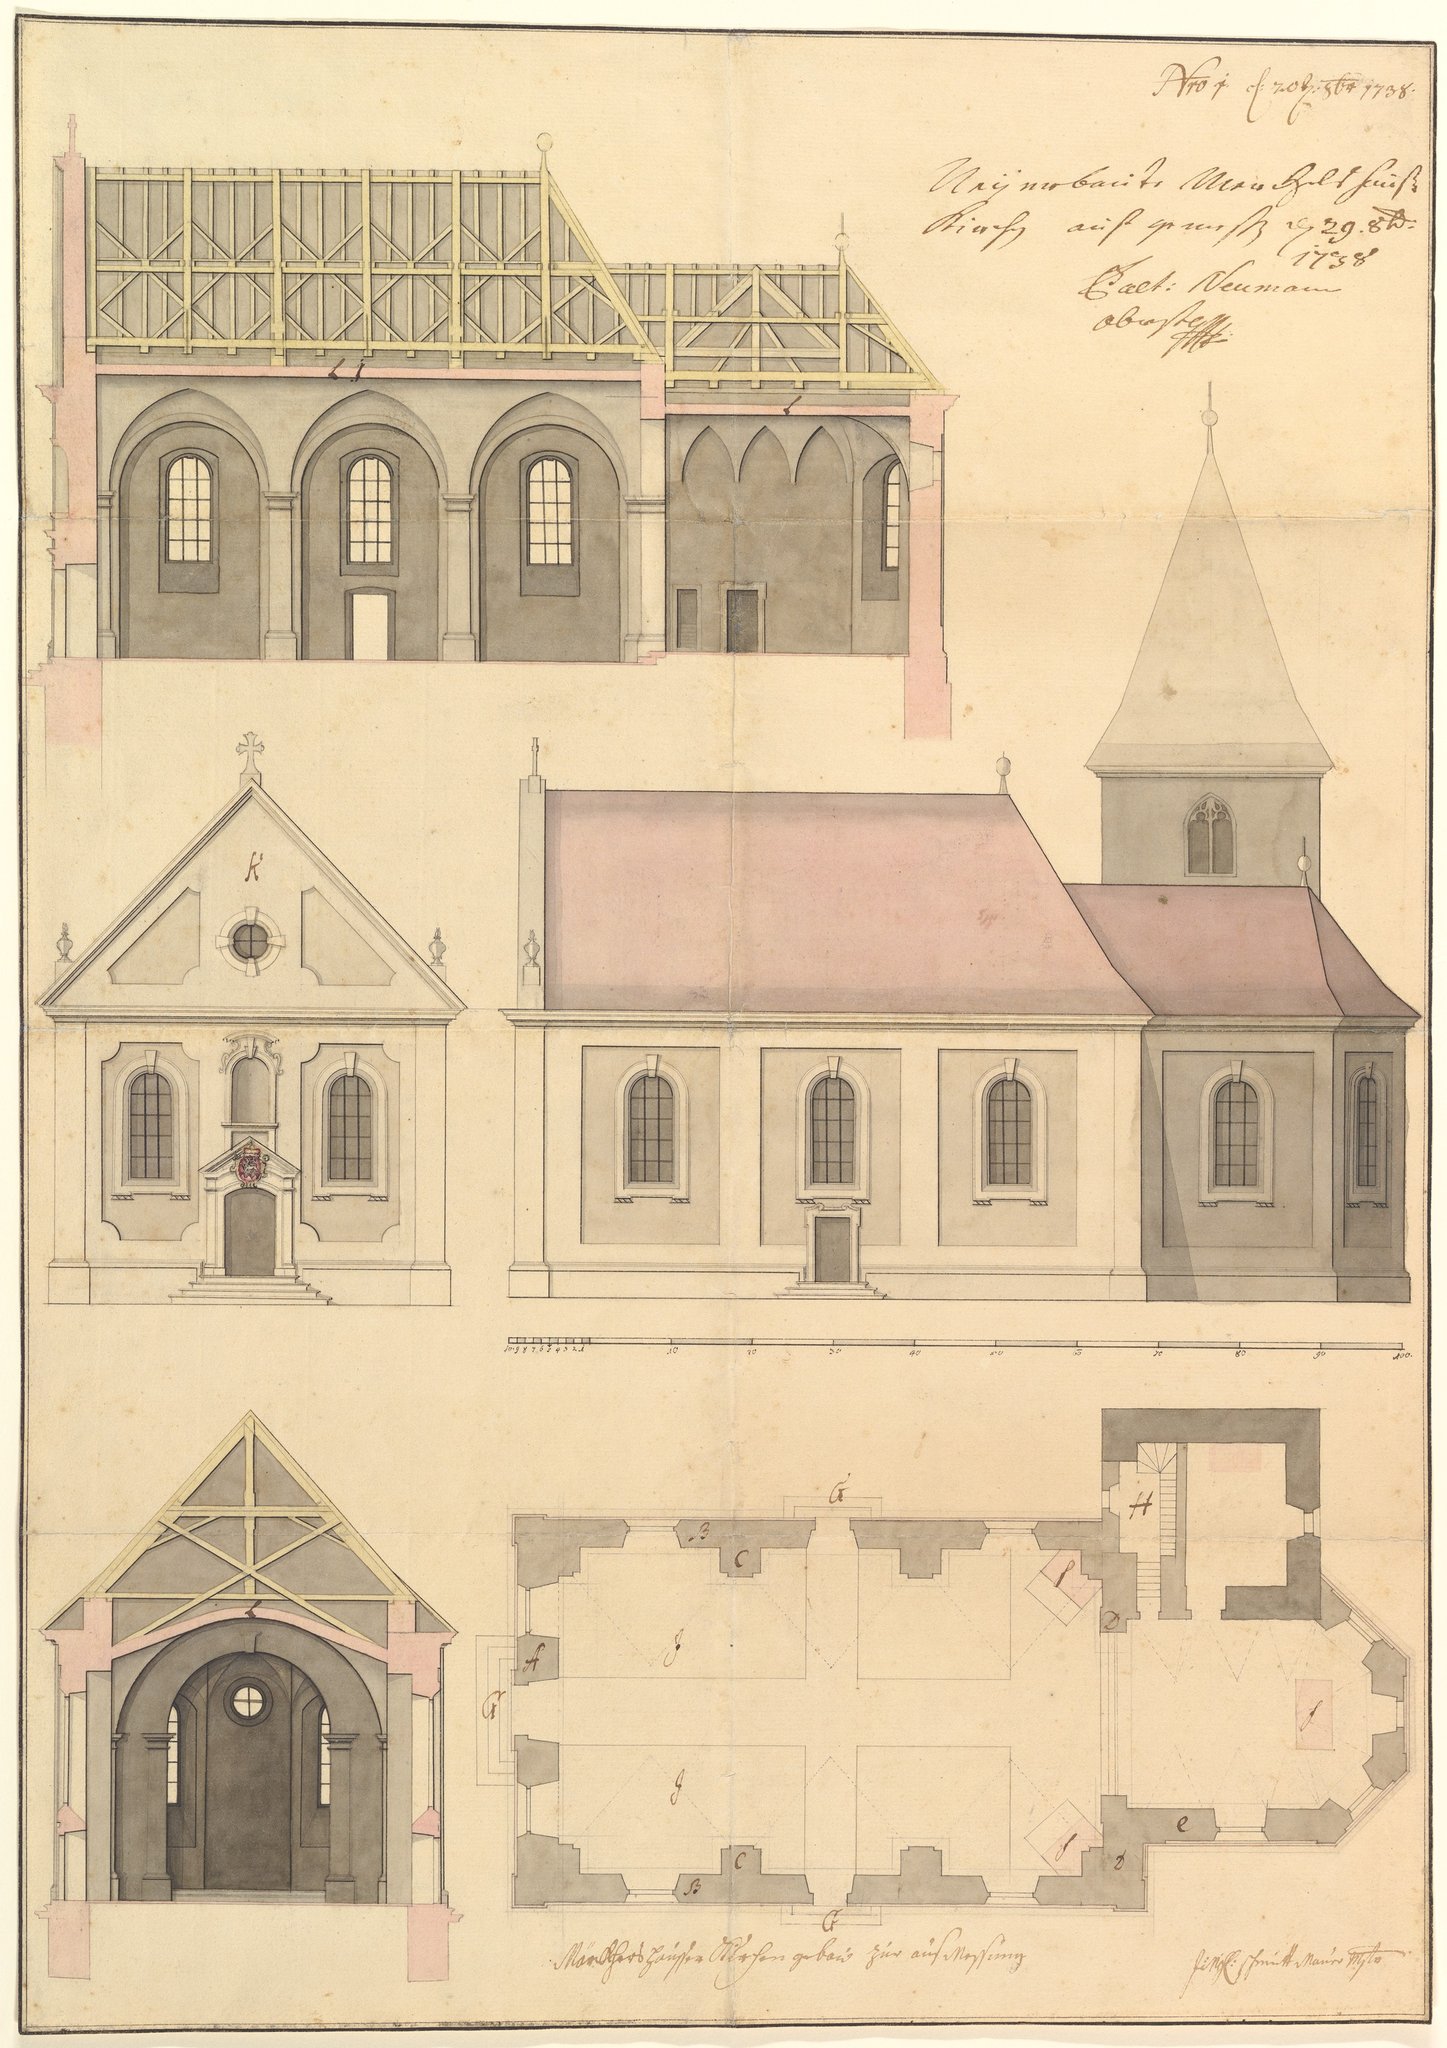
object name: drawing ornament architecture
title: Design for the Parish Church of Merkershausen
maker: balthasar neumann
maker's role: artist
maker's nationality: german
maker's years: 1687-1753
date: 1738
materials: chalk, graphite, ink, watercolor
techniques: pen, wash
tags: architecture,churches